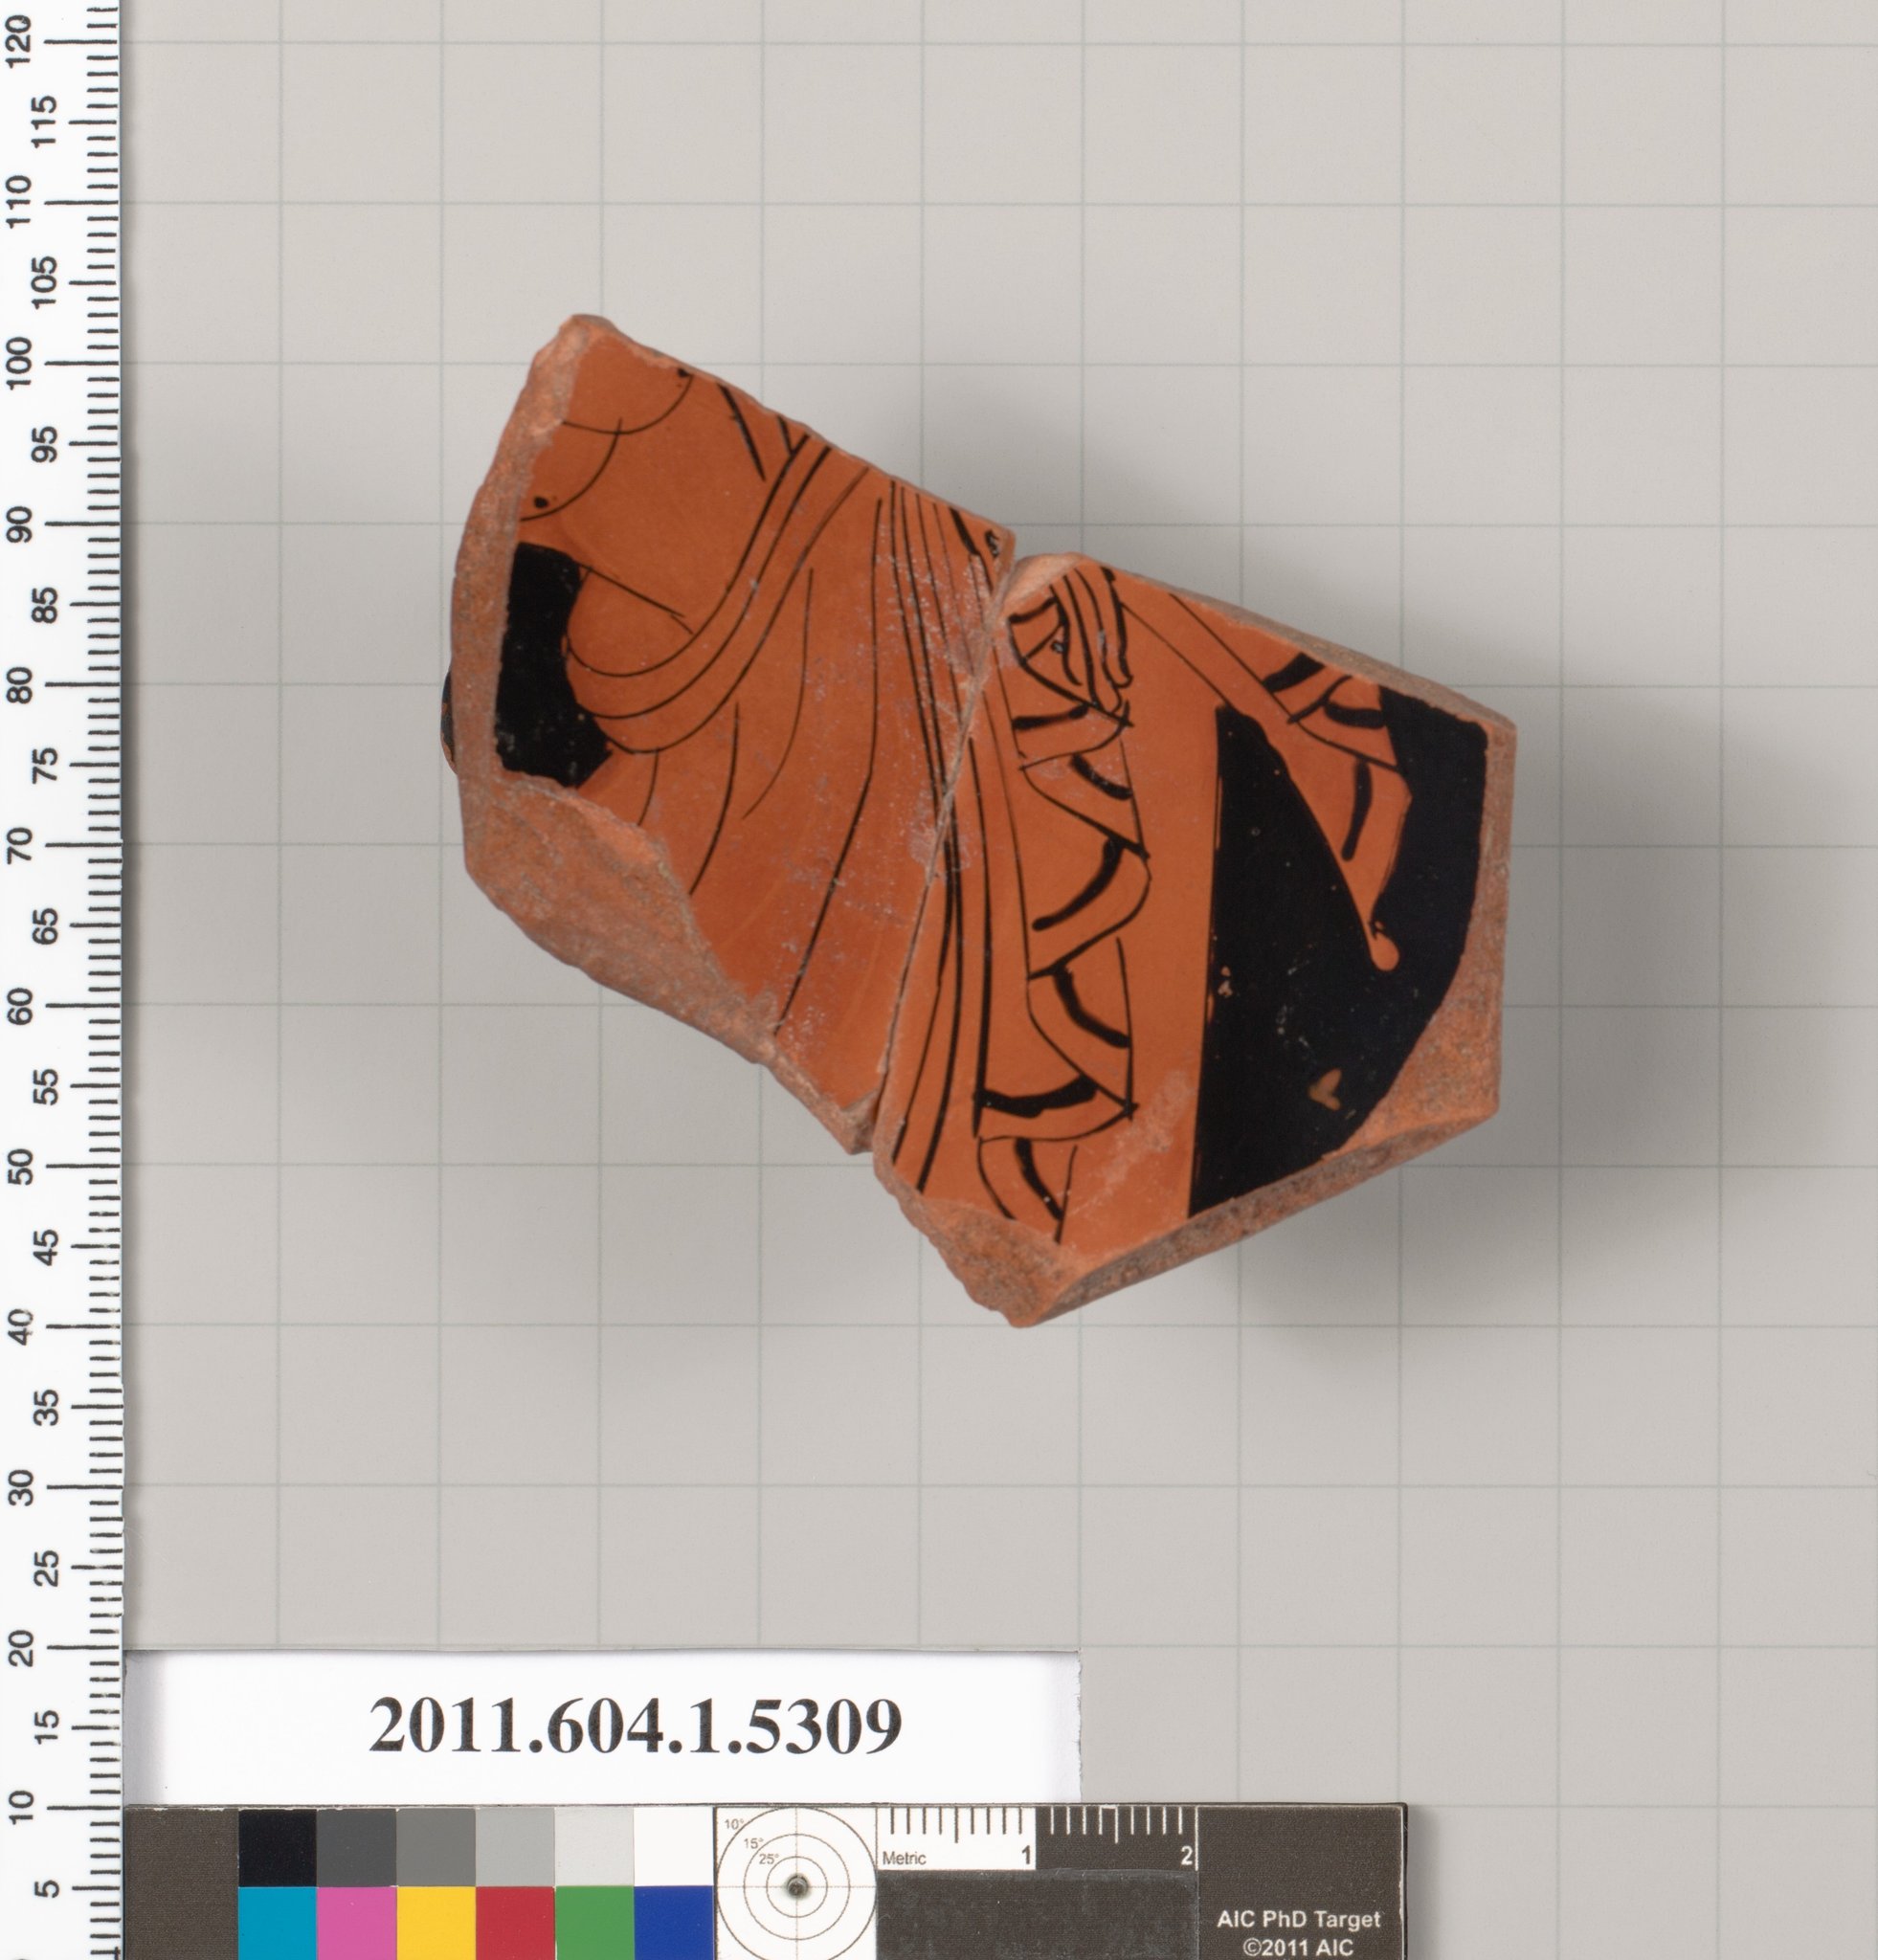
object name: kylix fragment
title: Terracotta fragment of a kylix (drinking cup)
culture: greek, attic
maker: chairias painter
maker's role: artist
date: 520-500 BCE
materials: terracotta